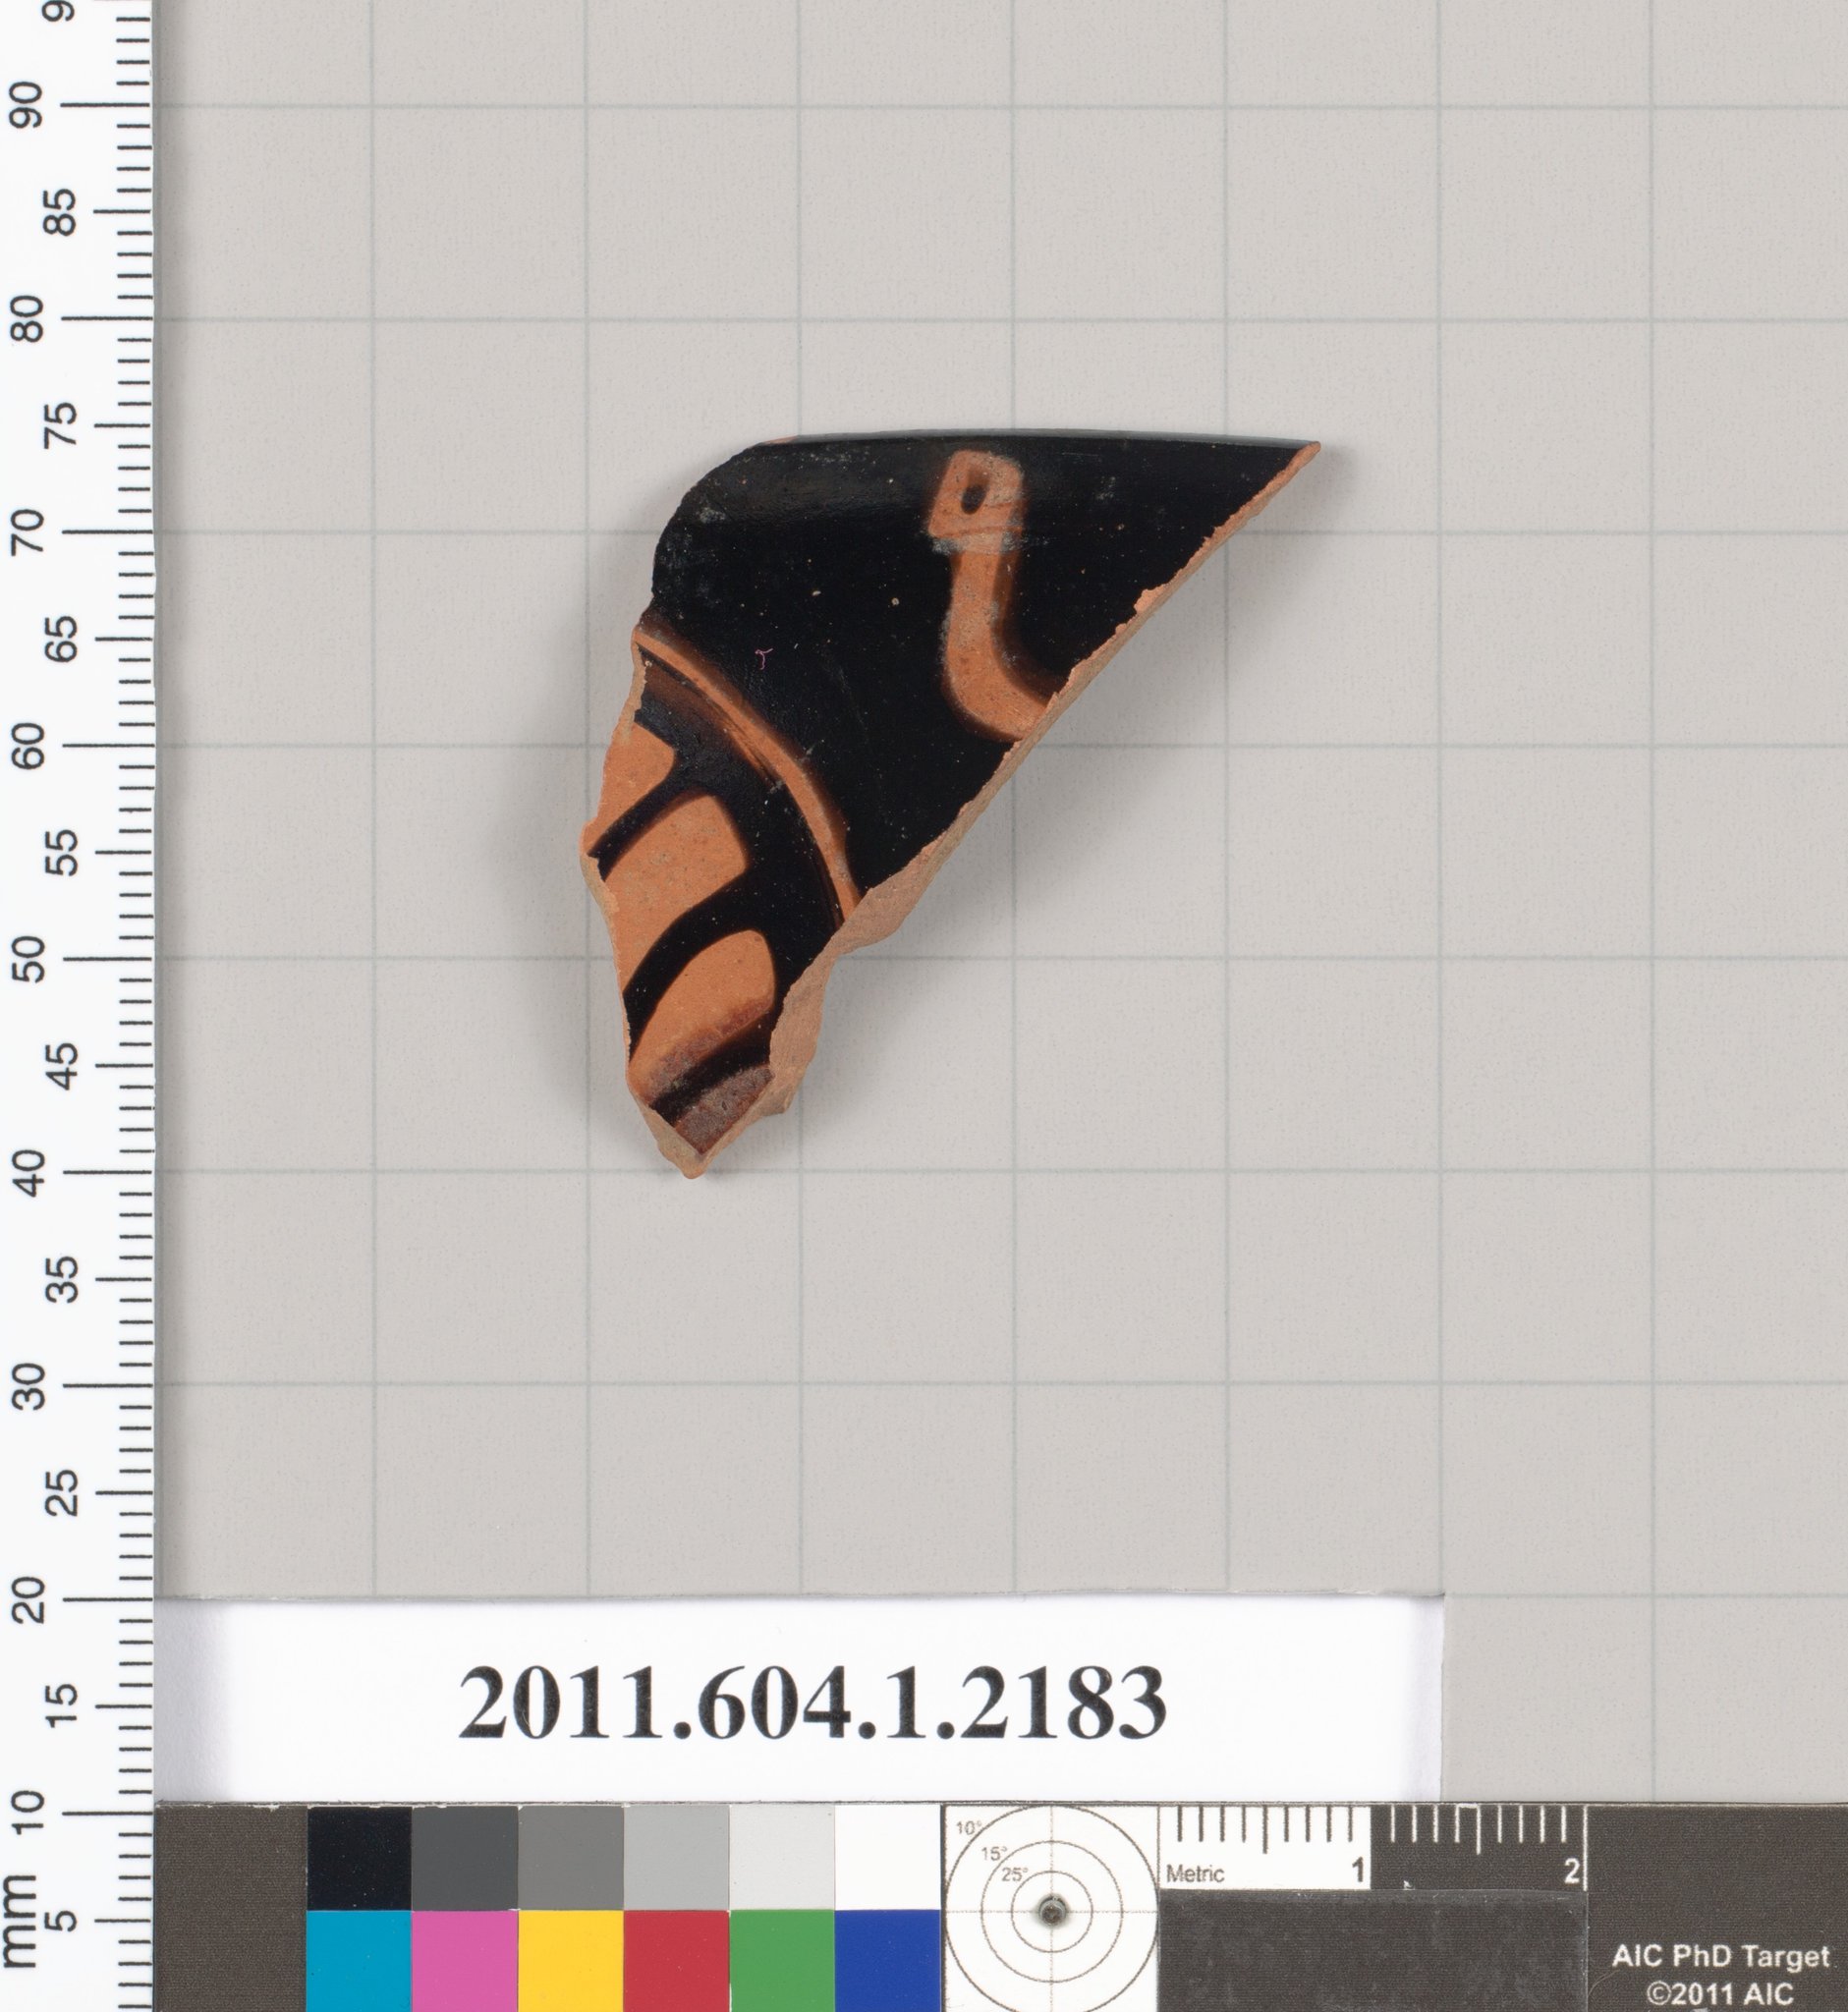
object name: kylix fragment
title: Terracotta rim fragment of a kylix (drinking cup)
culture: greek, attic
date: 467-435 BCE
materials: terracotta